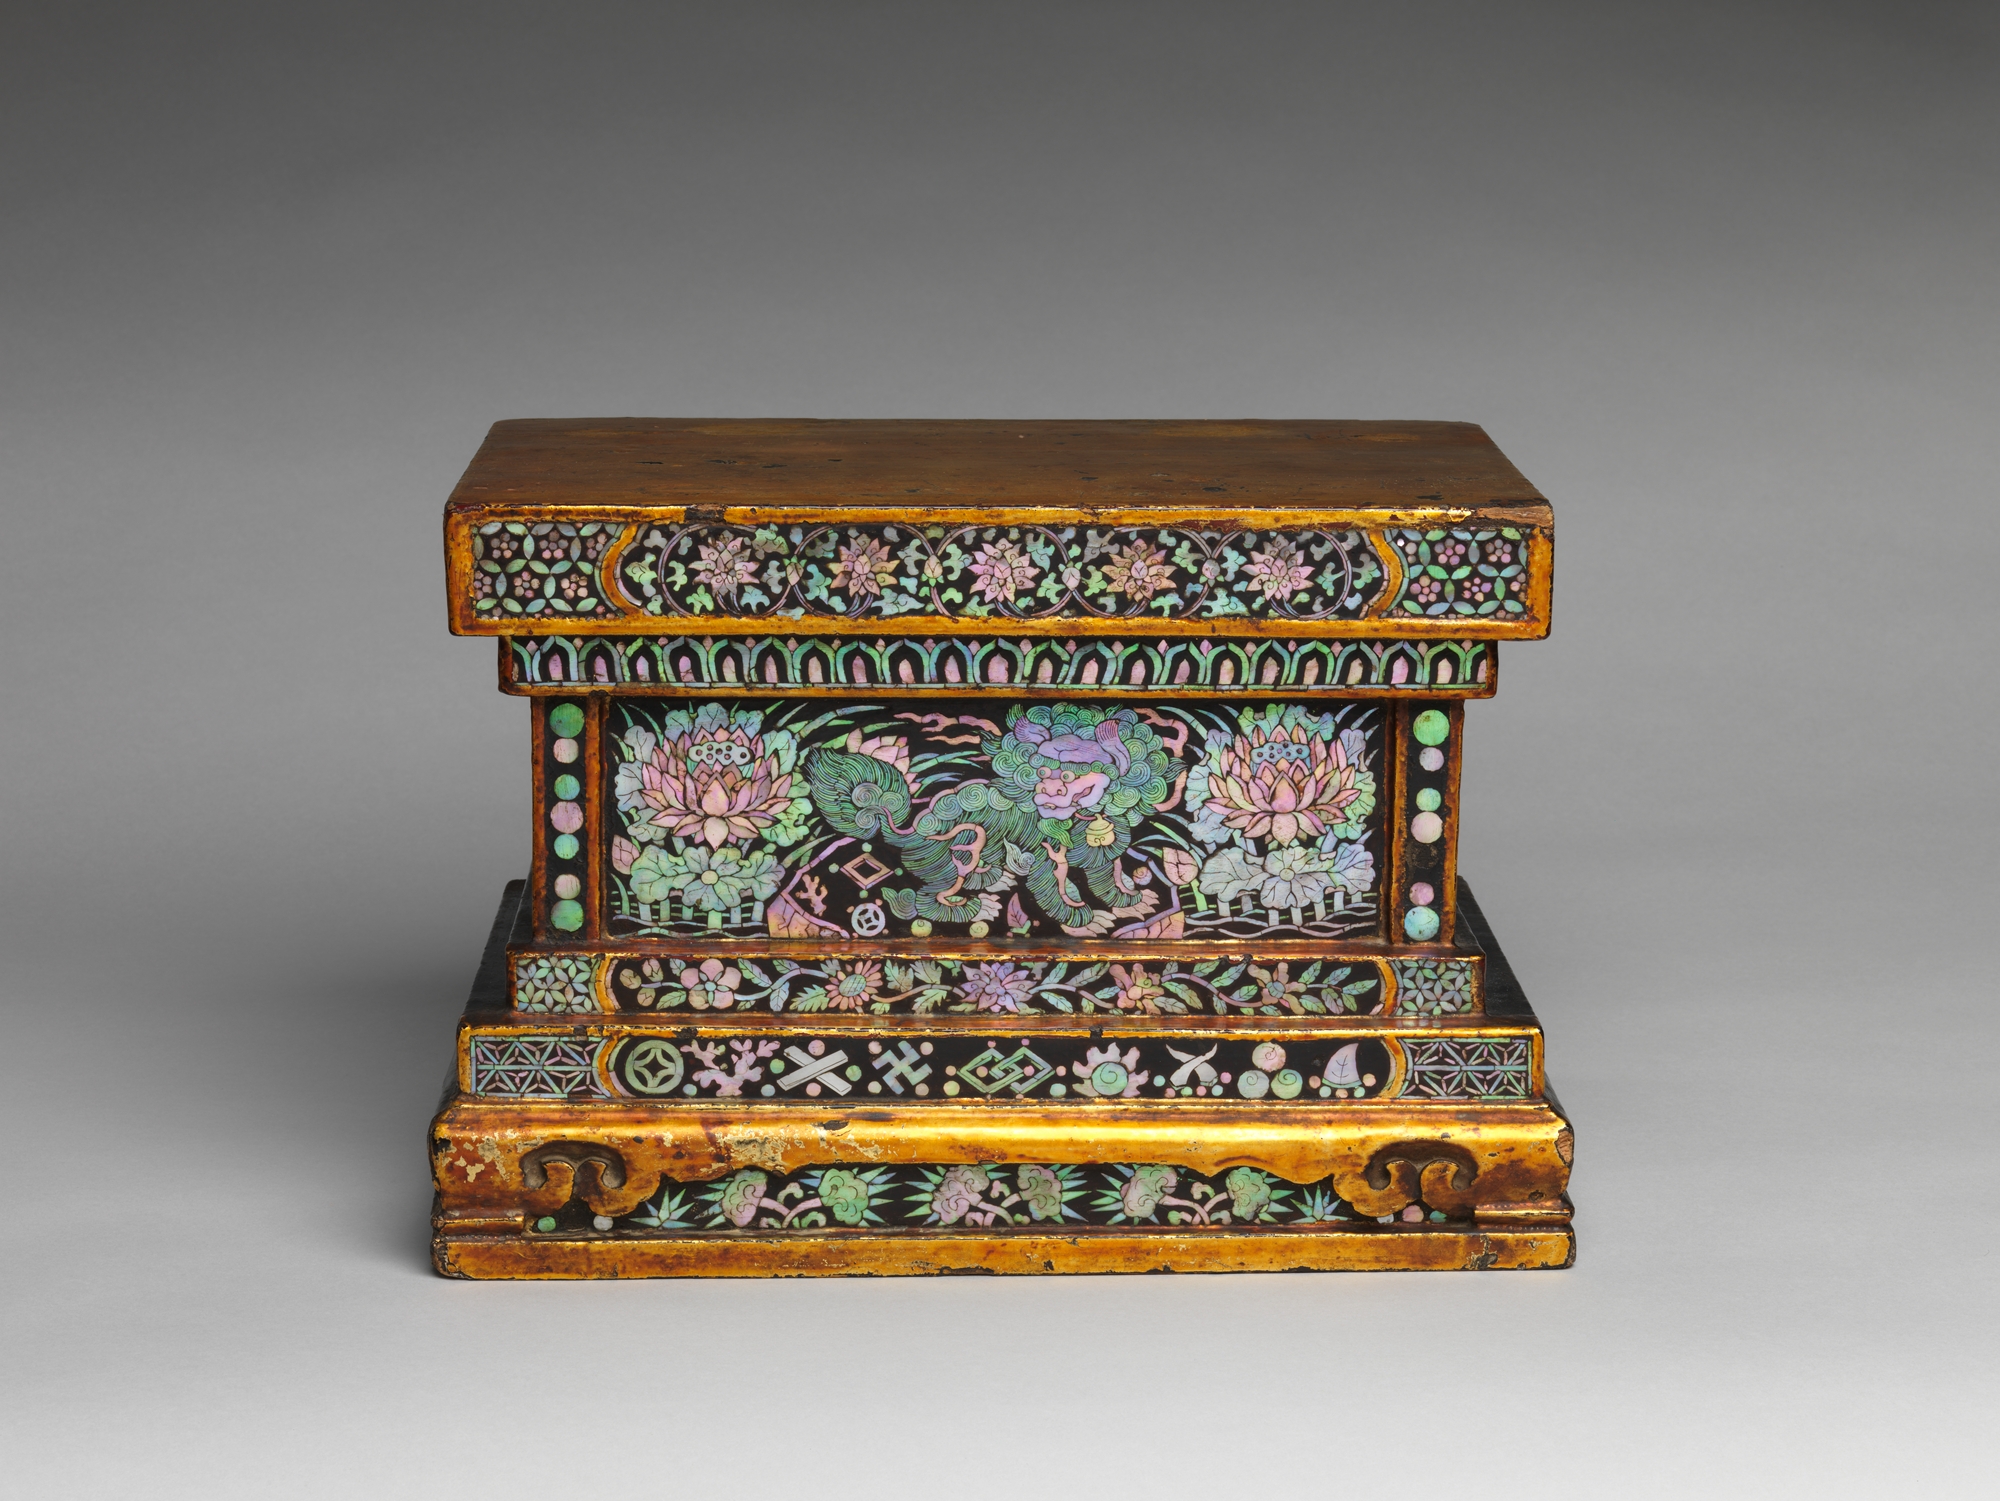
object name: pedestal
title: Pedestal, possibly for a sculpture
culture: chinese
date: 1501-1600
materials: lacquer, mother of pearl, wood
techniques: inlay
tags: animals,lotuses